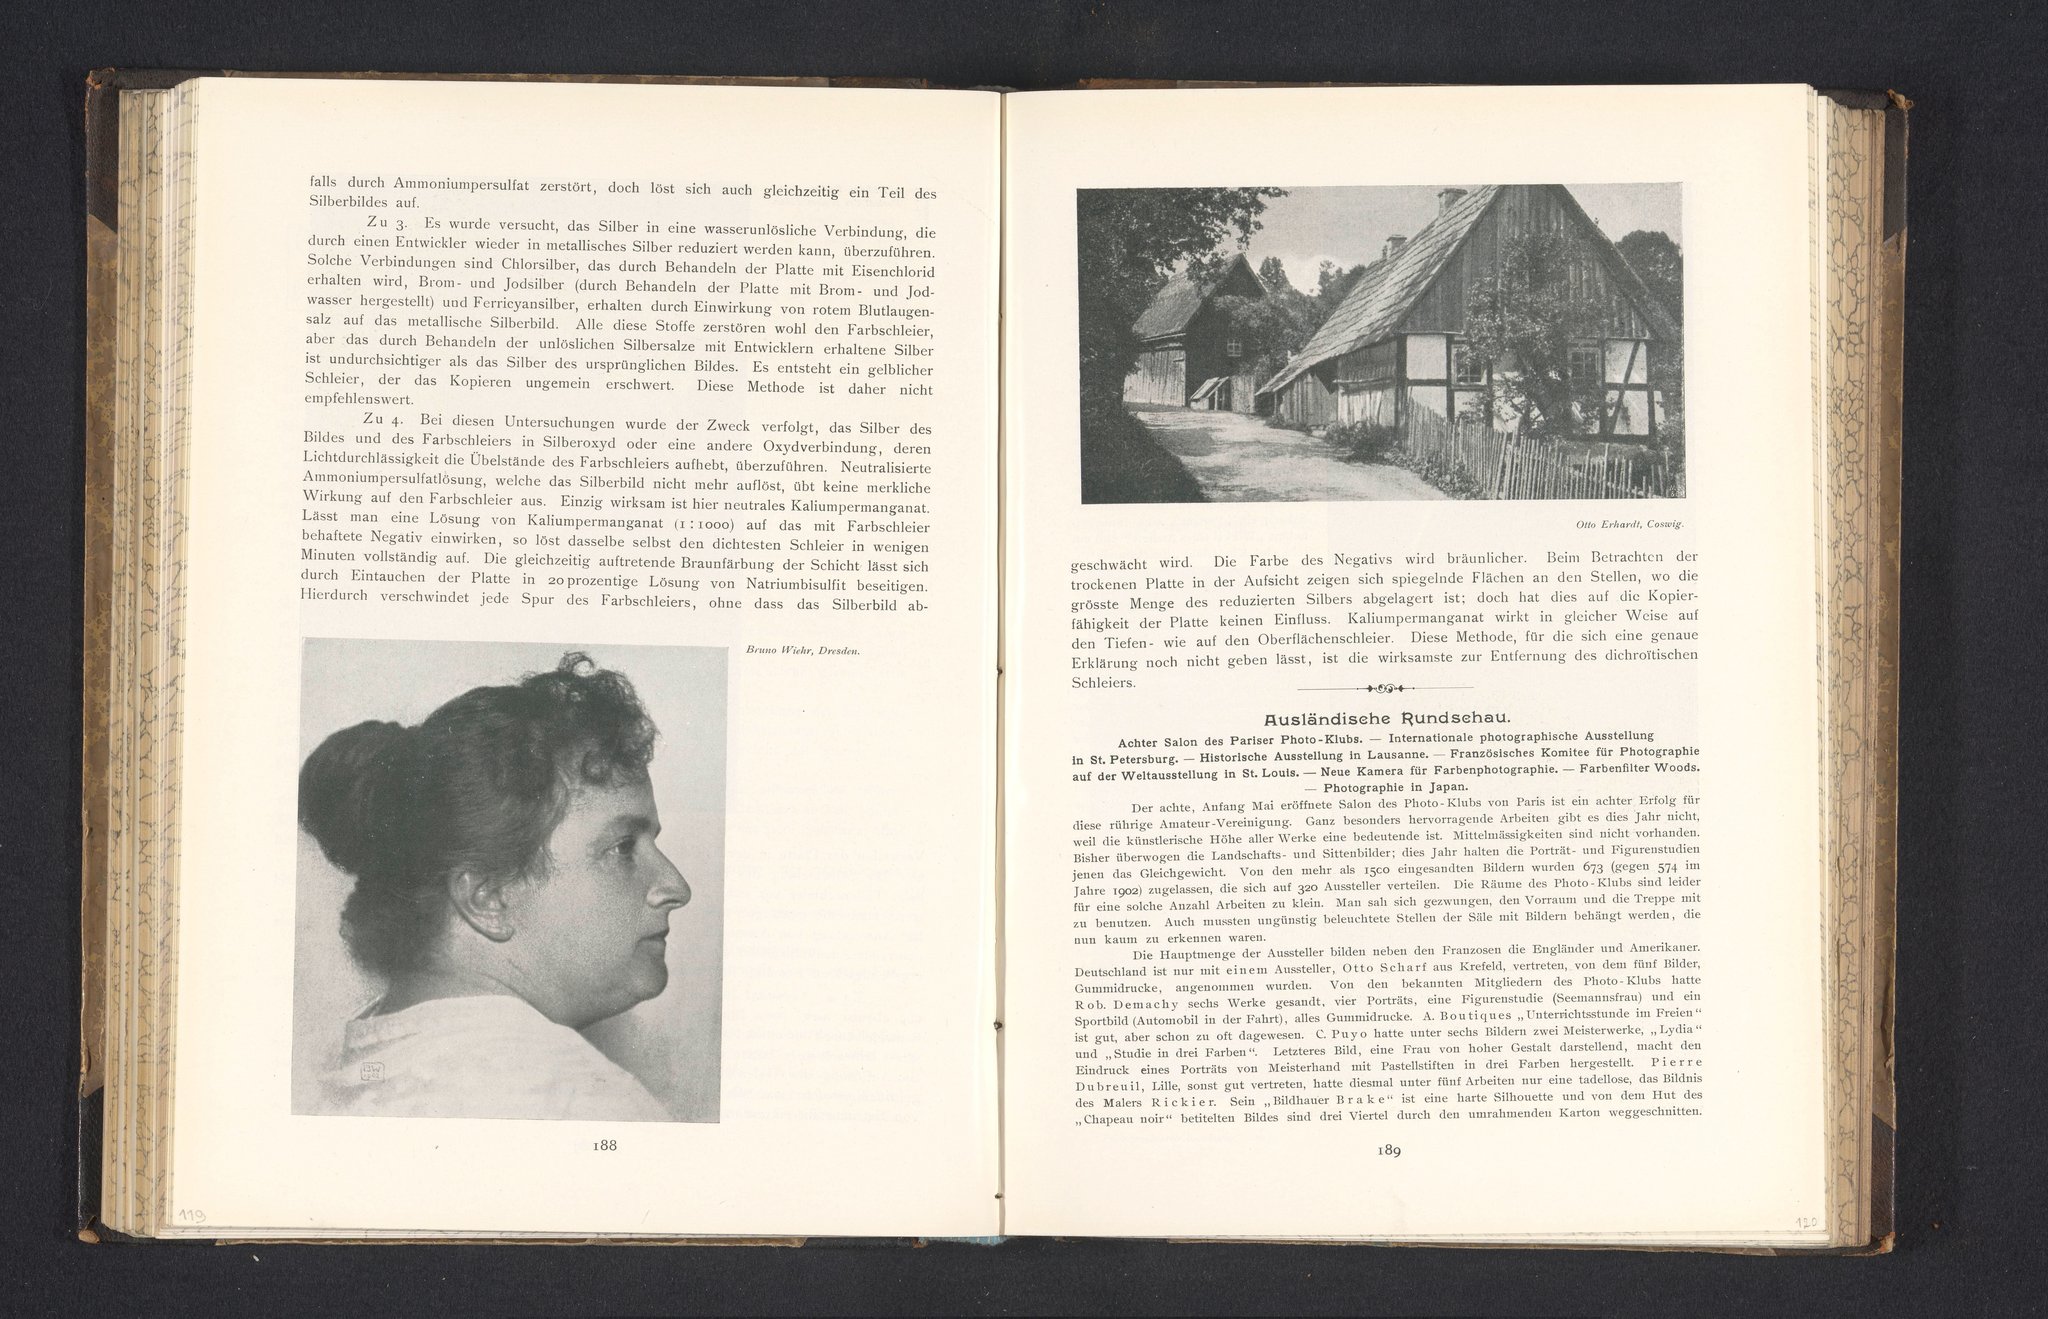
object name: page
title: Gezicht op een huis en bijgebouw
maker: otto erhardt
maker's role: fotograaf, leraar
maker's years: 1869-1942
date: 1898-1903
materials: paper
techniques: autotype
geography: berlin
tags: rural housing, e.g. country-house, villa, cottage